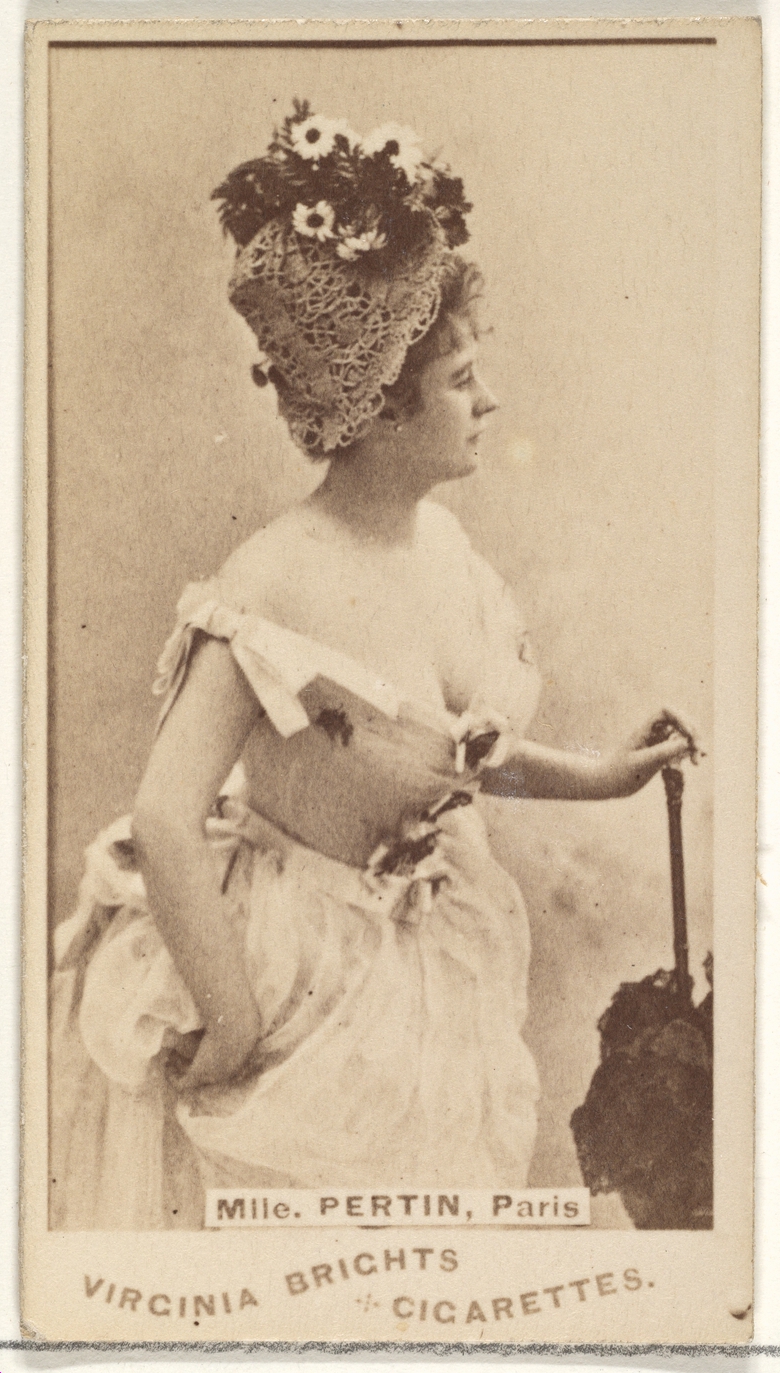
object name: photograph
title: Mlle. Pertin, Paris, from the Actors and Actresses series (N45, Type 1) for Virginia Brights Cigarettes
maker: allen & ginter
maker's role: publisher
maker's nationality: american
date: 1888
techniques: albumen silver print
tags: portraits,profiles,women,actresses